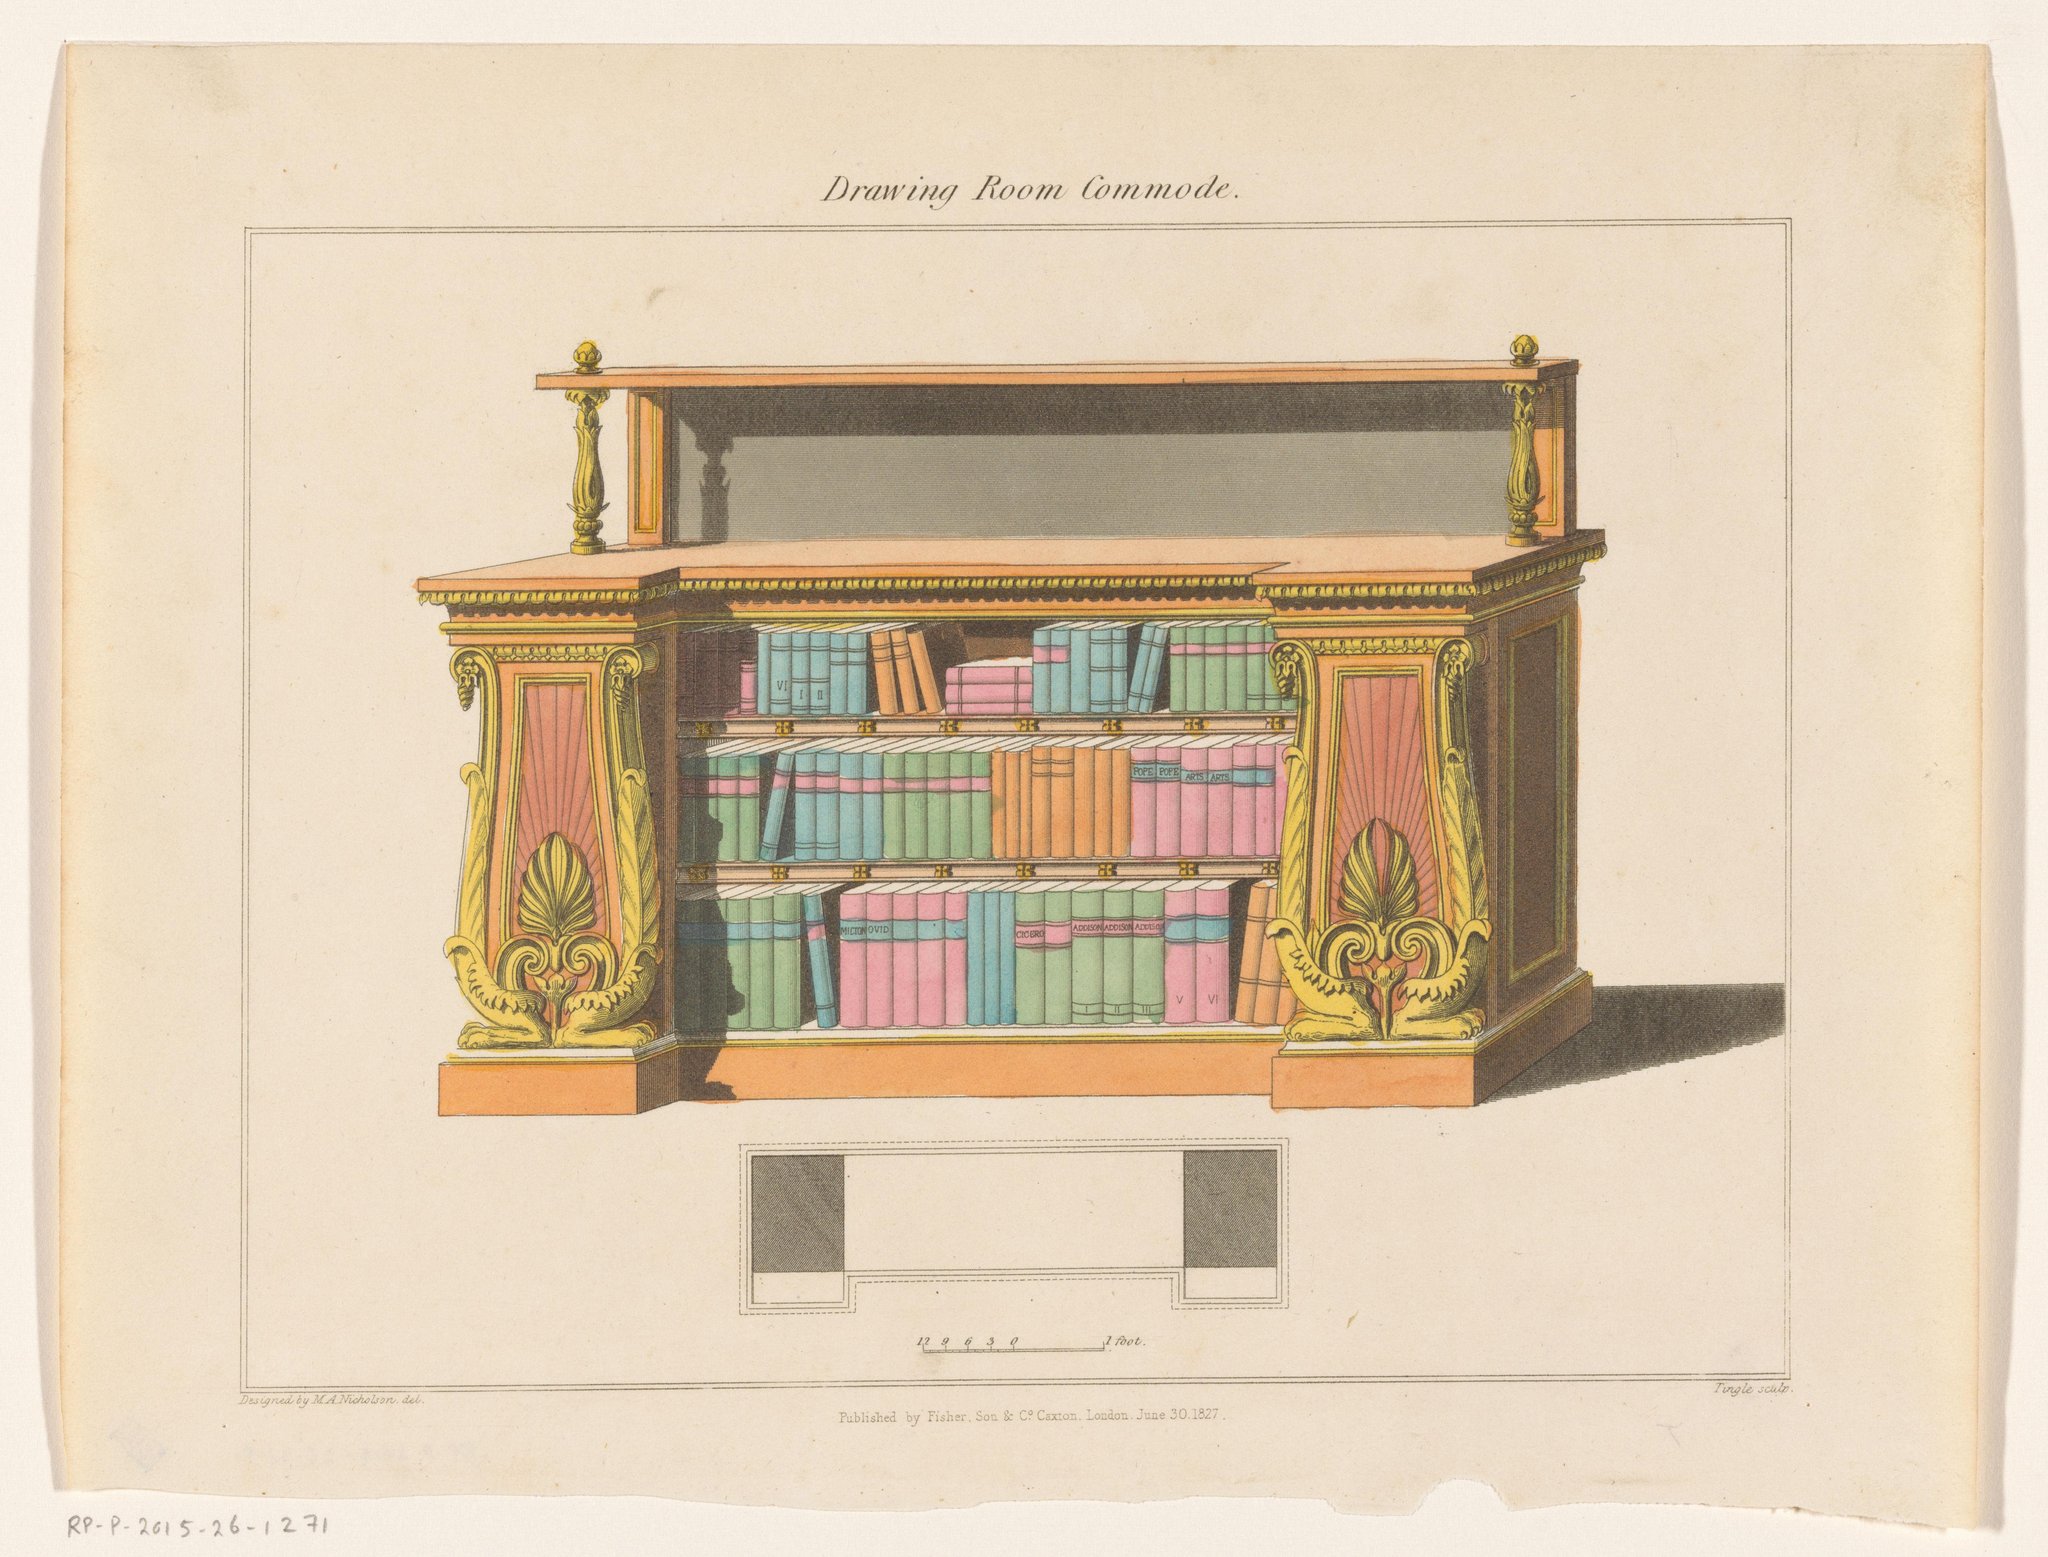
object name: book illustration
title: Drawing Room Commode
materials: paper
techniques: etching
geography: london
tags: bookshelves, furniture for storage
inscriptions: collector's mark: Lugt 2228, collector's mark: Lugt 4780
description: Prent waarschijnlijk afkomstig uit: Nicholson, Peter en Michael Angelo. The Practical Cabinet-Maker, Upholsterer and Complete Decorator. Londen: Fisher Son & Co., 1827.